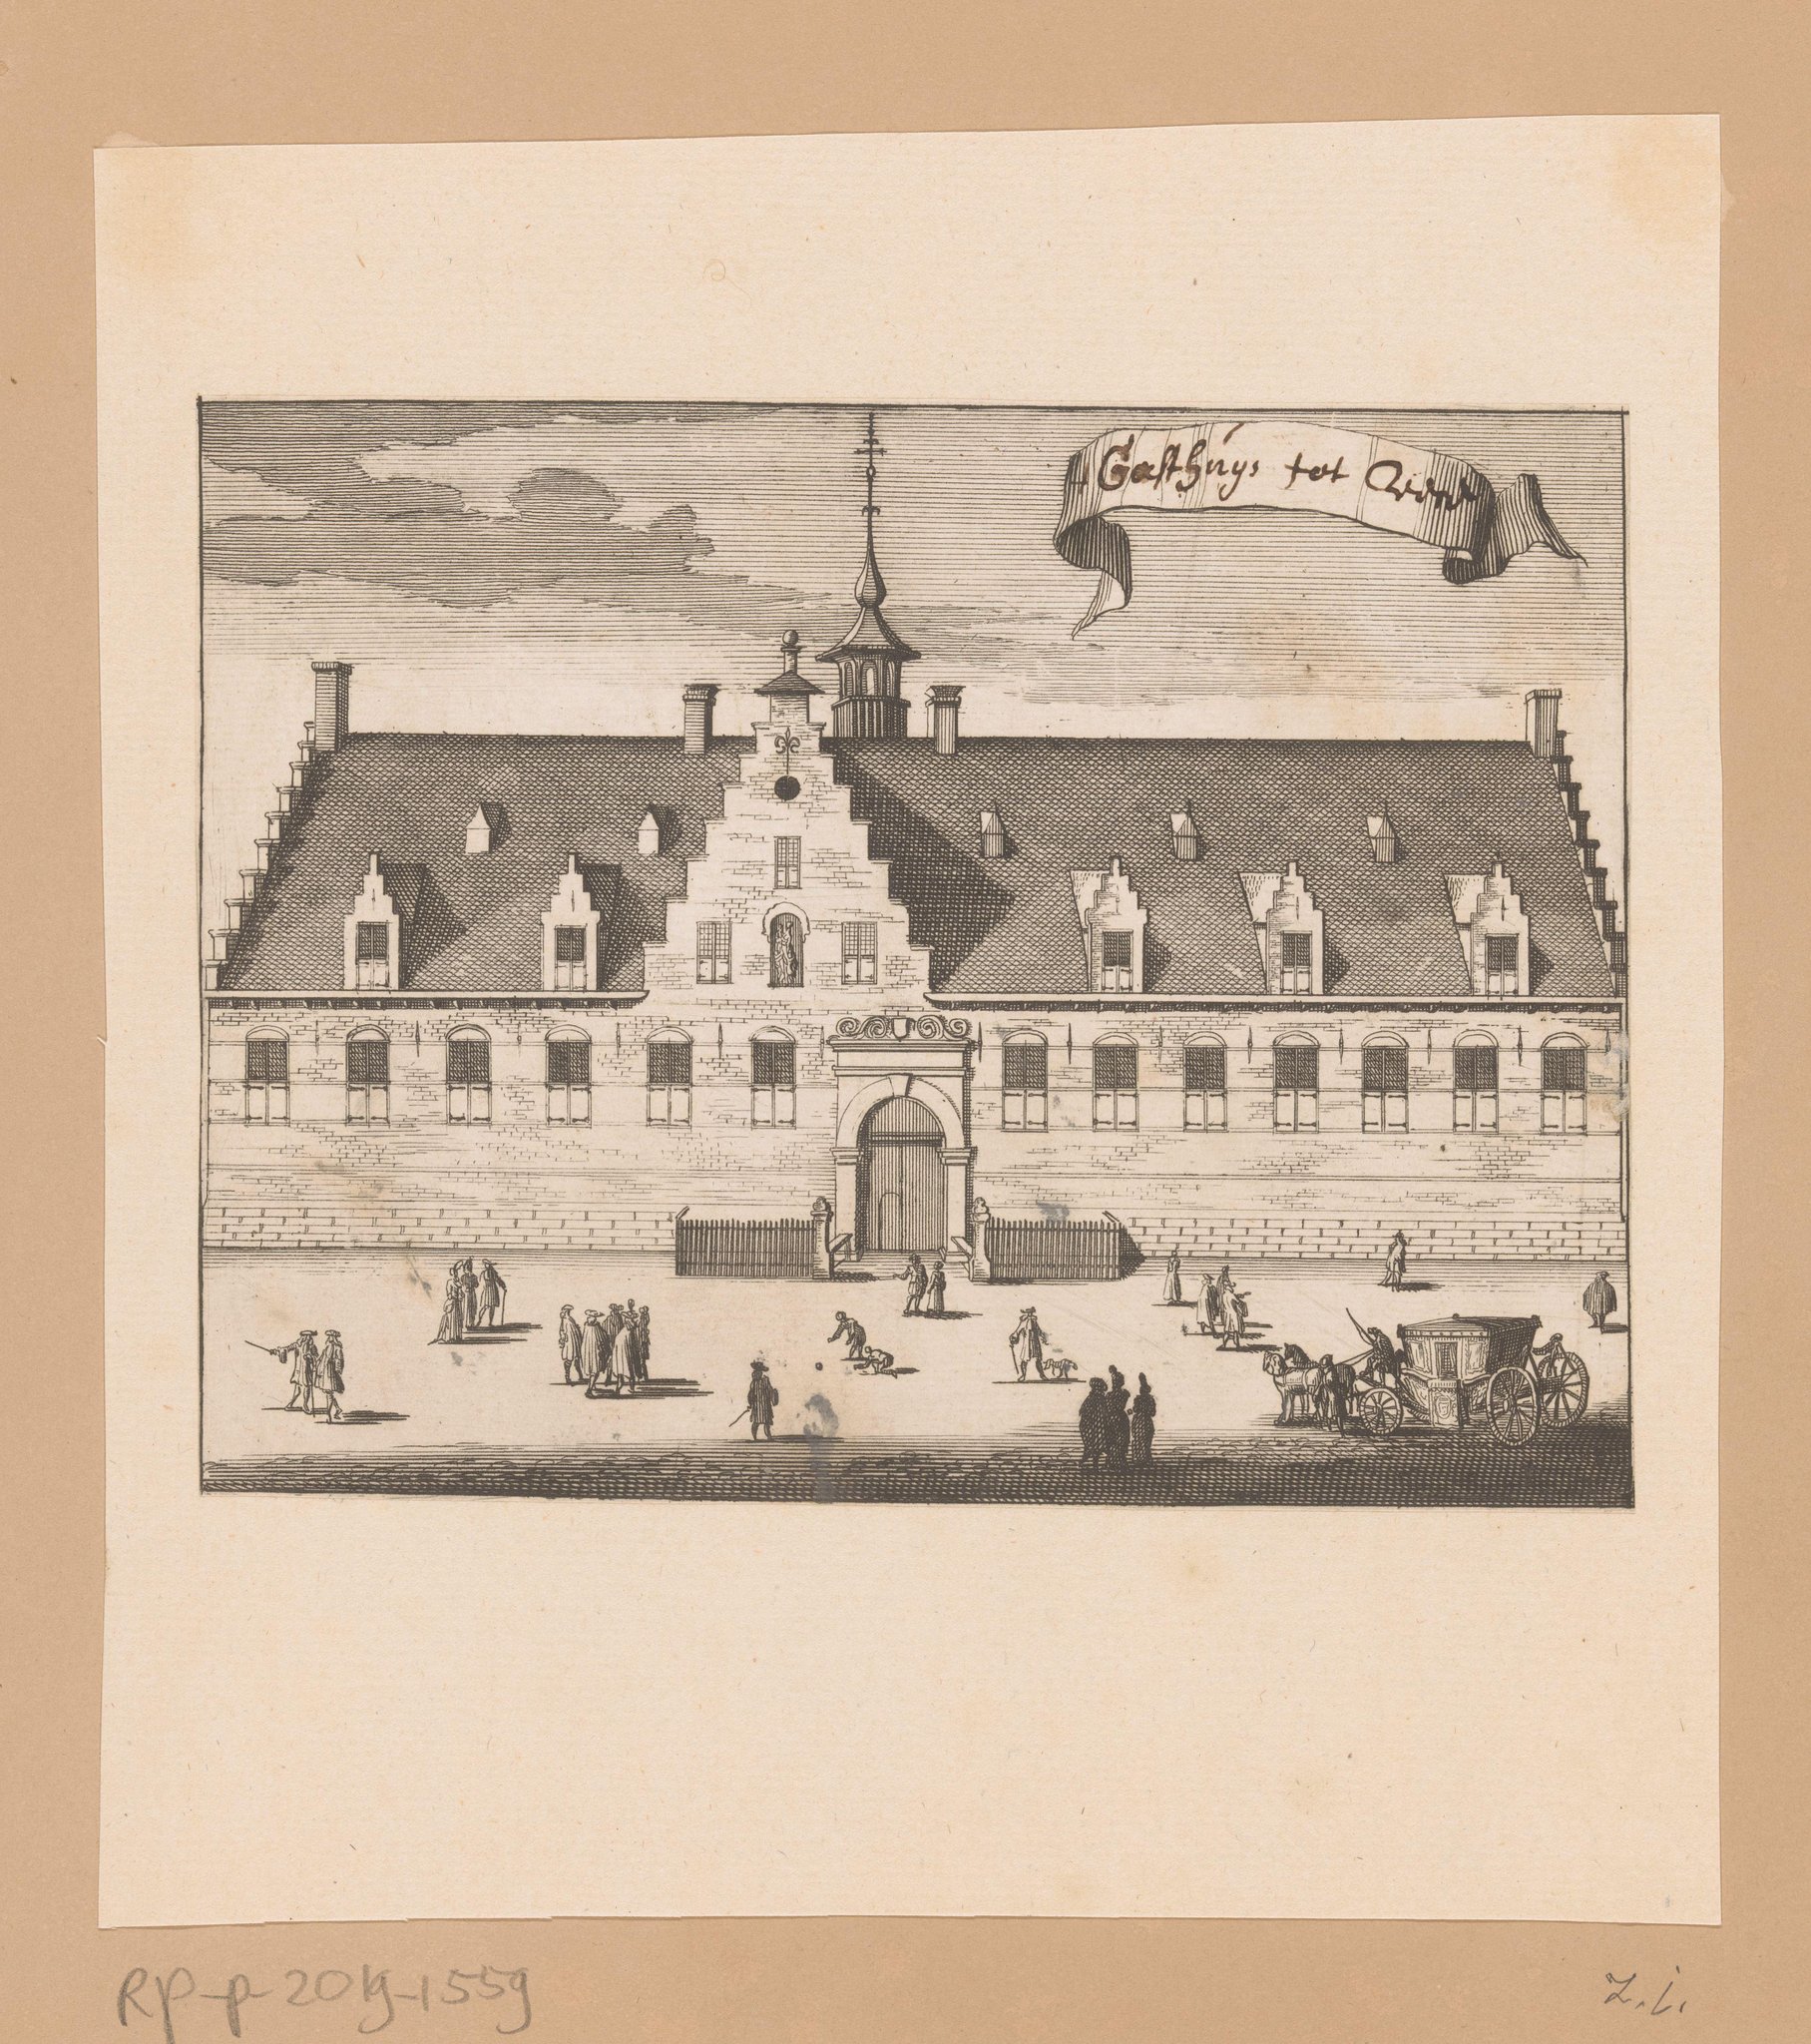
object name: print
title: Gezicht op het gasthuis te Veere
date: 1696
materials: paper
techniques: etching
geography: amsterdam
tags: hospital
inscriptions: inscription: ‘'t Gasthuys tot Vere’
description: Latere staat gebruikt in: Smallegange, Mattheus. Nieuwe Cronyk van Zeeland (...). Middelburg: Johannes Meertens, Amsterdam: Abraham van Someren, 1696, p. 583.